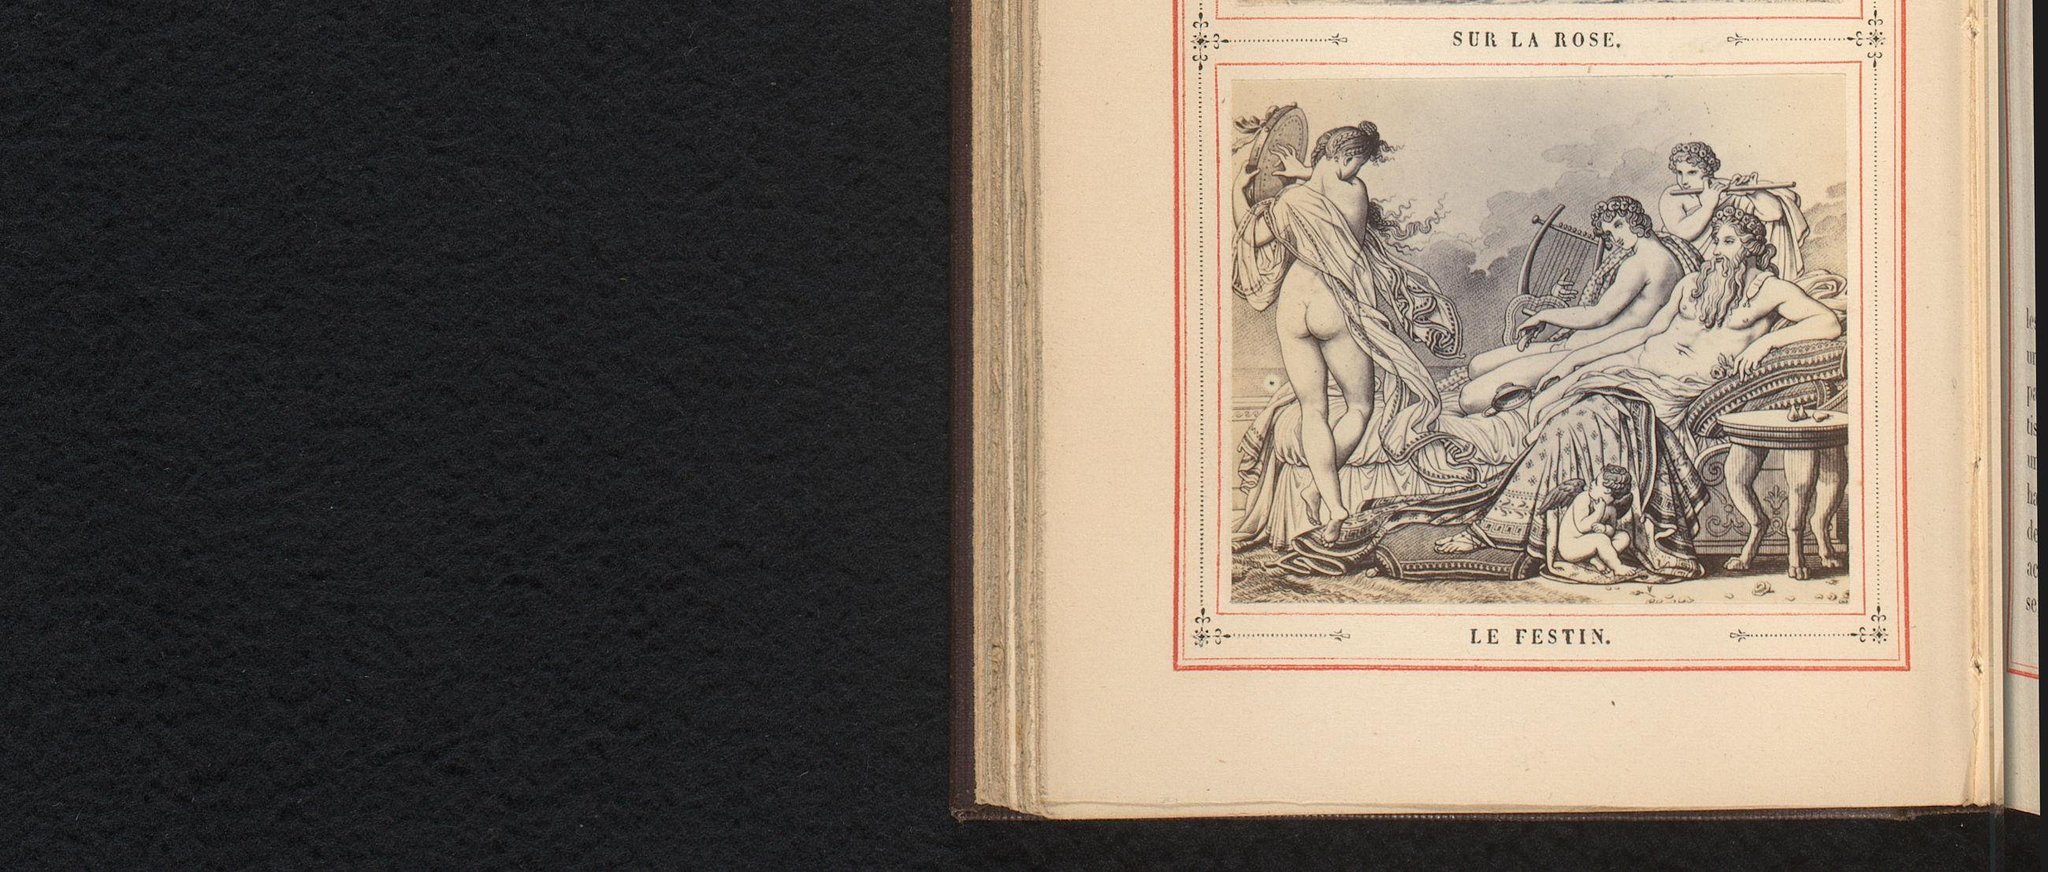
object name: reproduction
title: Fotoreproductie van een tekening van Girodet, feestende goden, illustratie bij Apothéose d'Anacréon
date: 1859-1864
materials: paper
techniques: albumen print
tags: gods ~ classical mythology